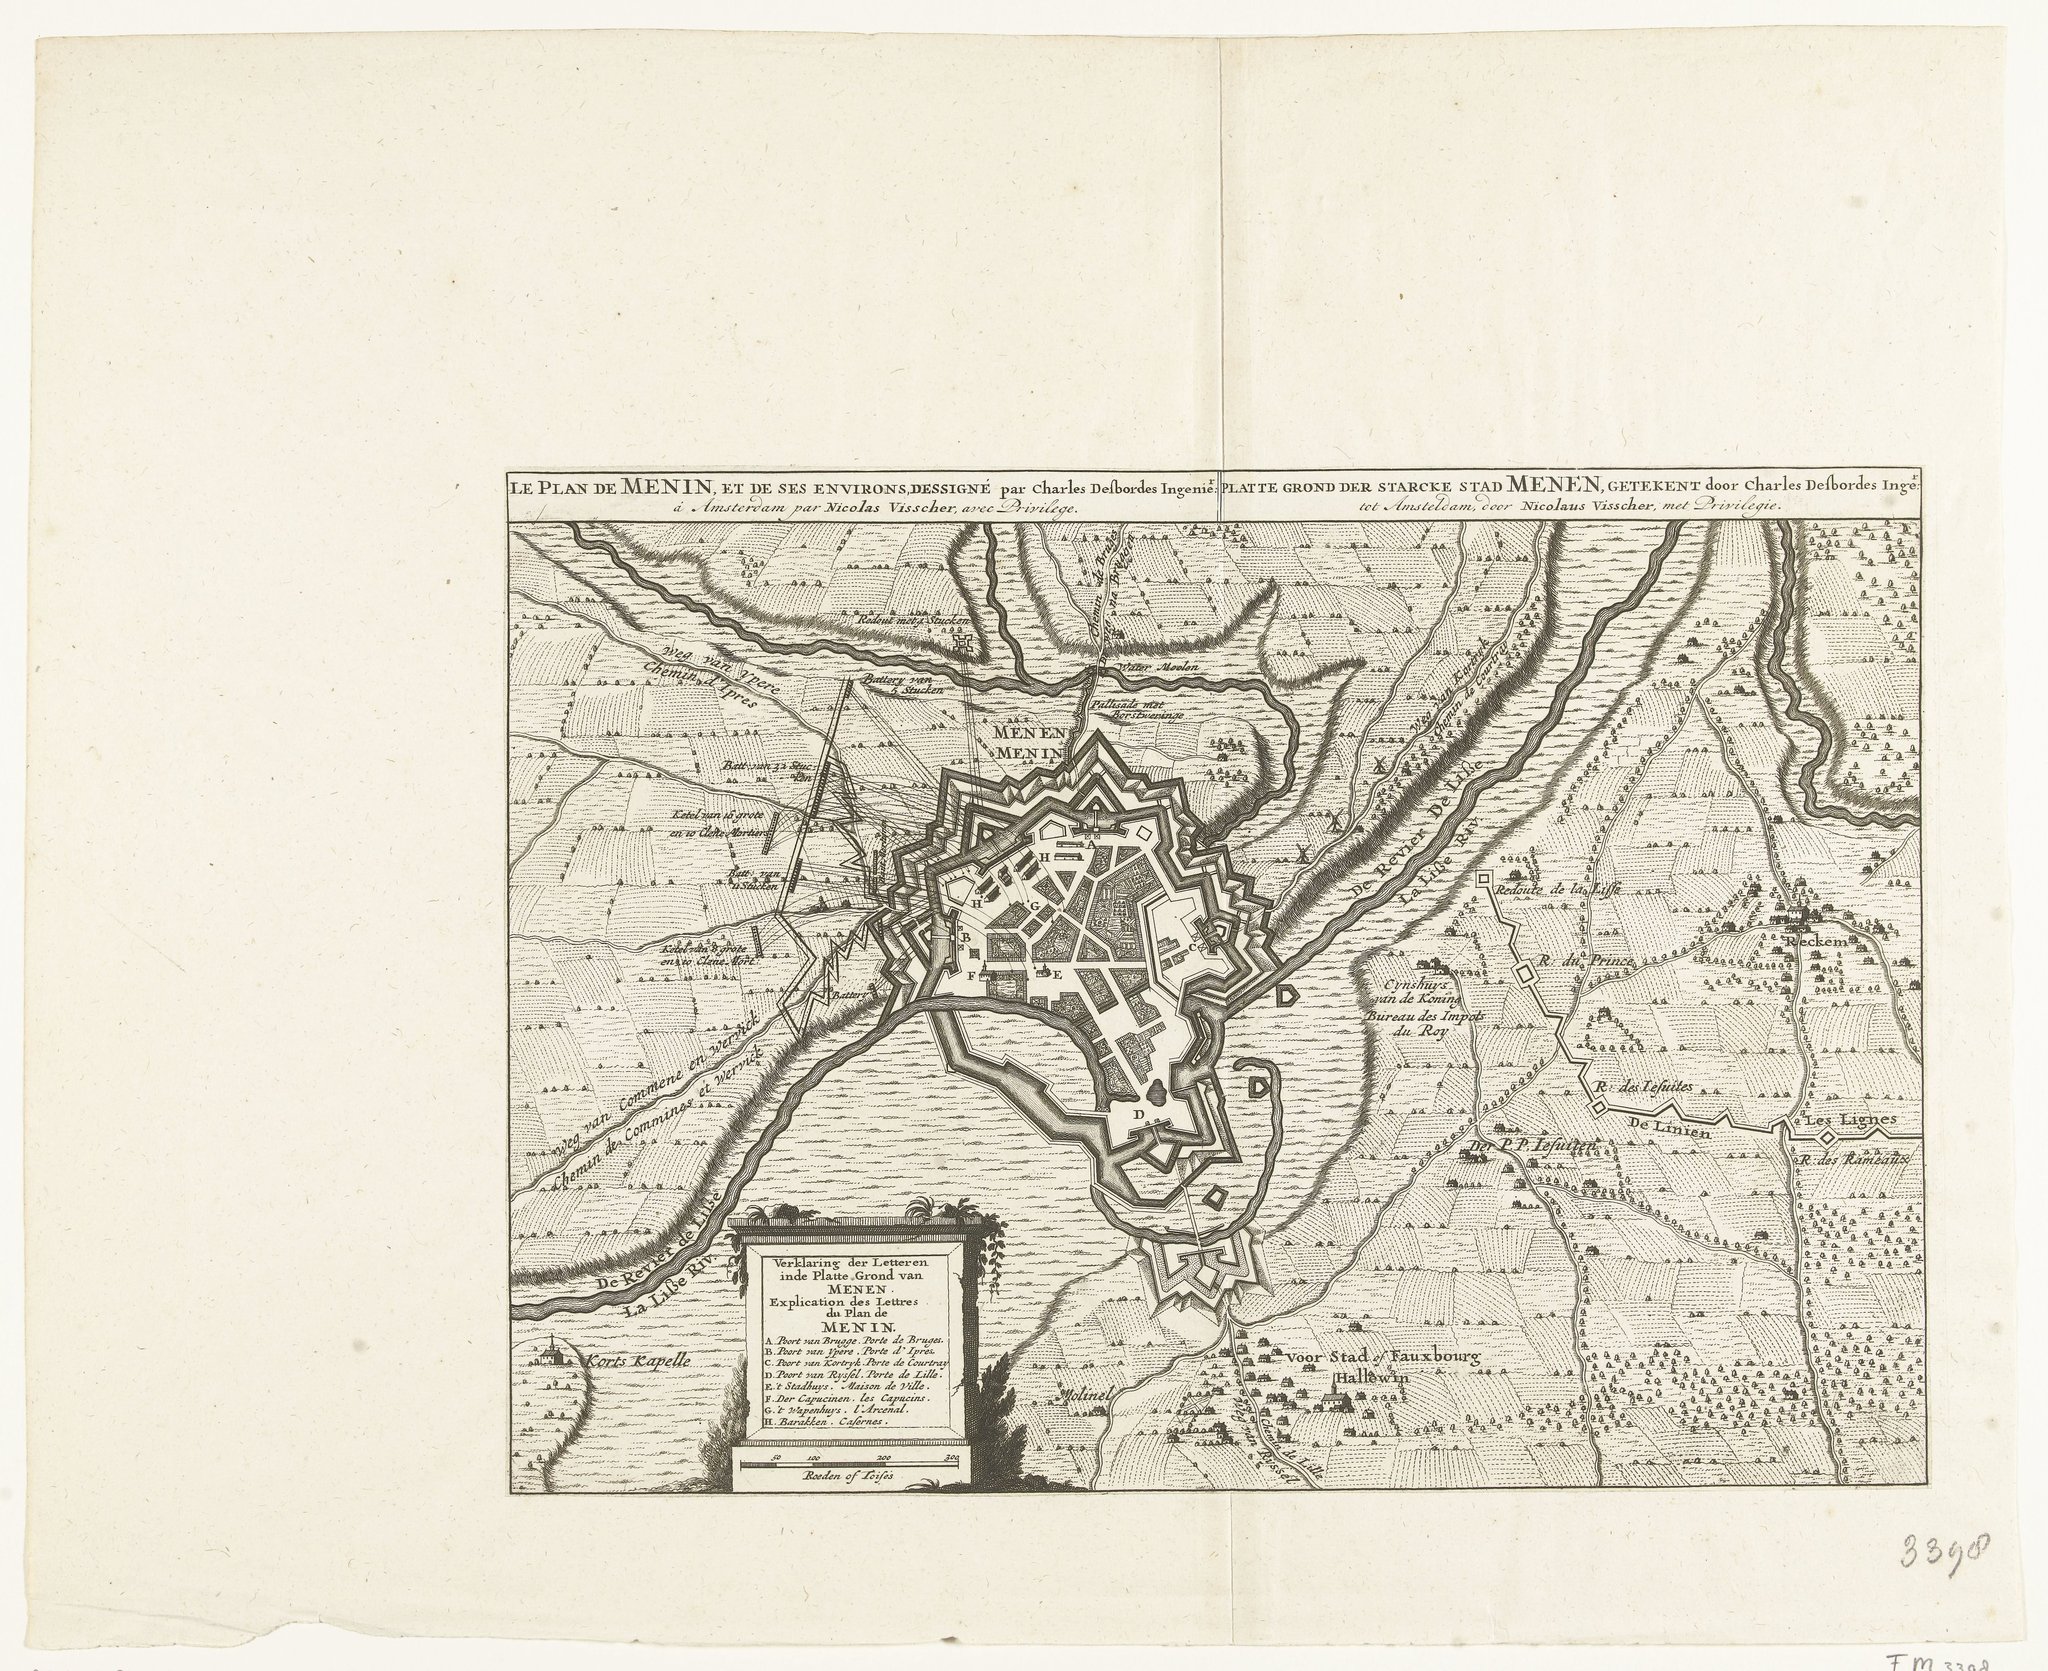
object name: area plan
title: Le plan de Menin, et de ses environs / Platte grond der starcke stad Menen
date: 1706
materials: paper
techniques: etching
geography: amsterdam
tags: siege, position war, maps of cities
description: Plan van het beleg van Menen door de Geallieerden onder generaal E.W. von Salisch, ingenomen op 22 augustus 1706. In een balk boven de kaart de titel in het Nederlands en in het Frans. Onder, links van het midden, een cartouche met legenda A-H en schaalstok: 300 Roeden of Toises.